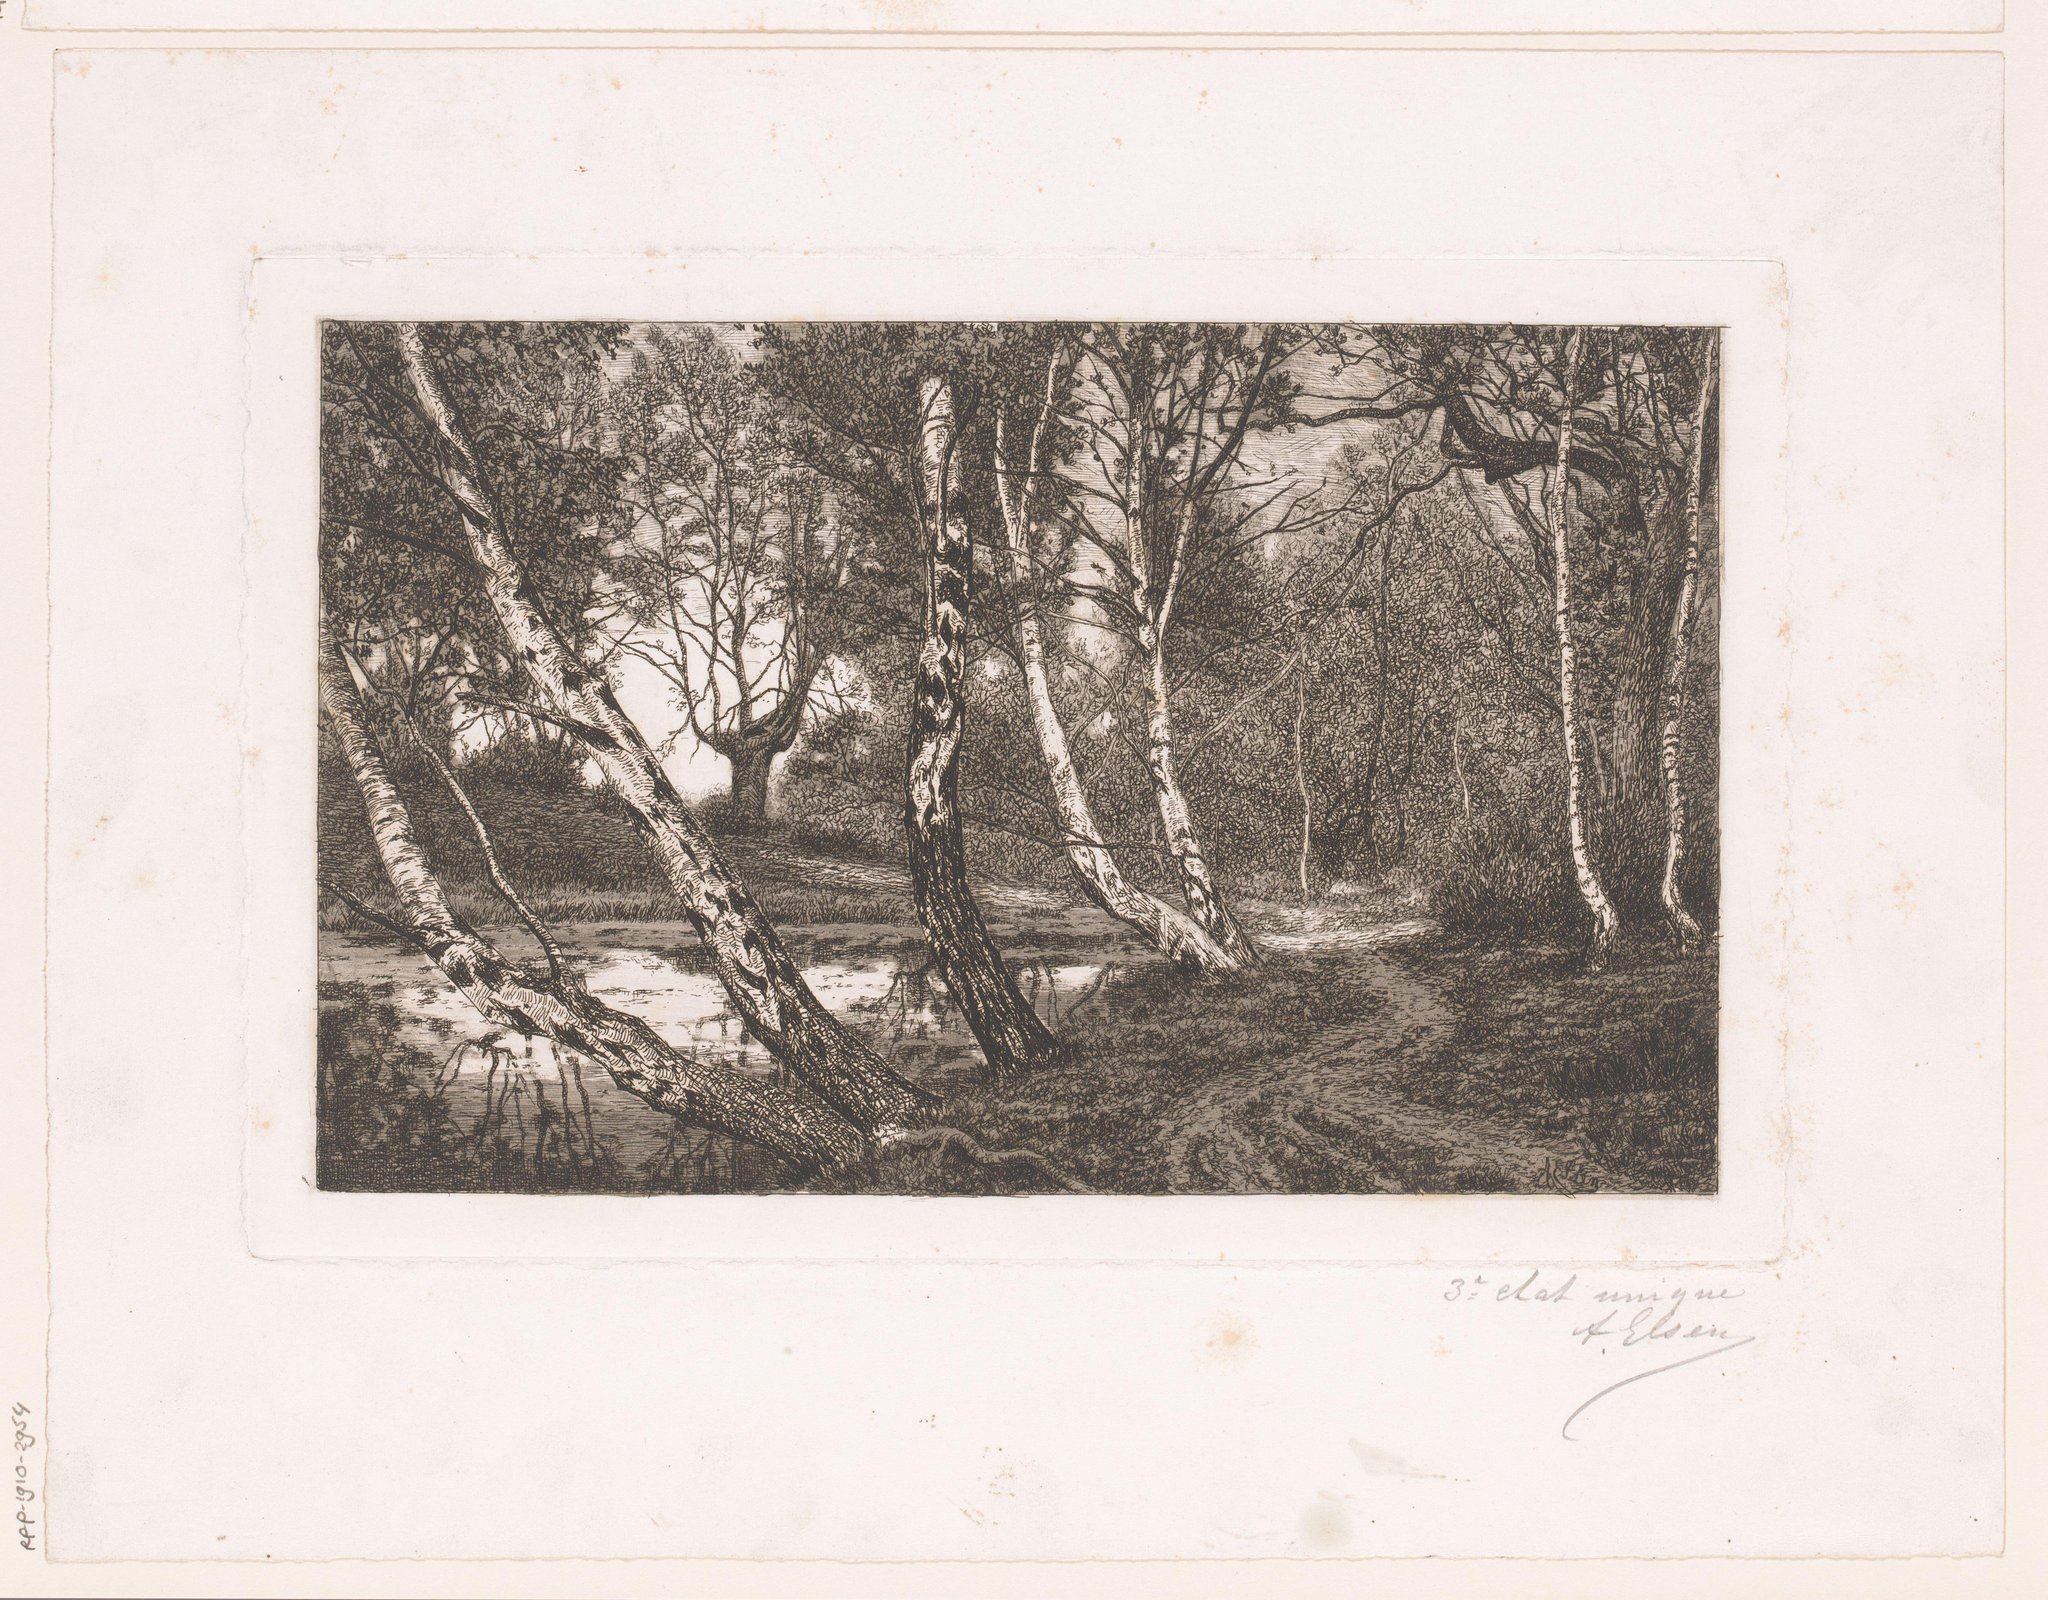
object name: print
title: Landschap met berken langs een oever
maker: alfred elsen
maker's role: painter, print maker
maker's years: 1850-1914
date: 1860-1910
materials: paper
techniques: etching, intaglio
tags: lake, forest path or lane, trees: birch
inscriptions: inscription: ‘3e etat unique’, collector's mark: Lugt 2228